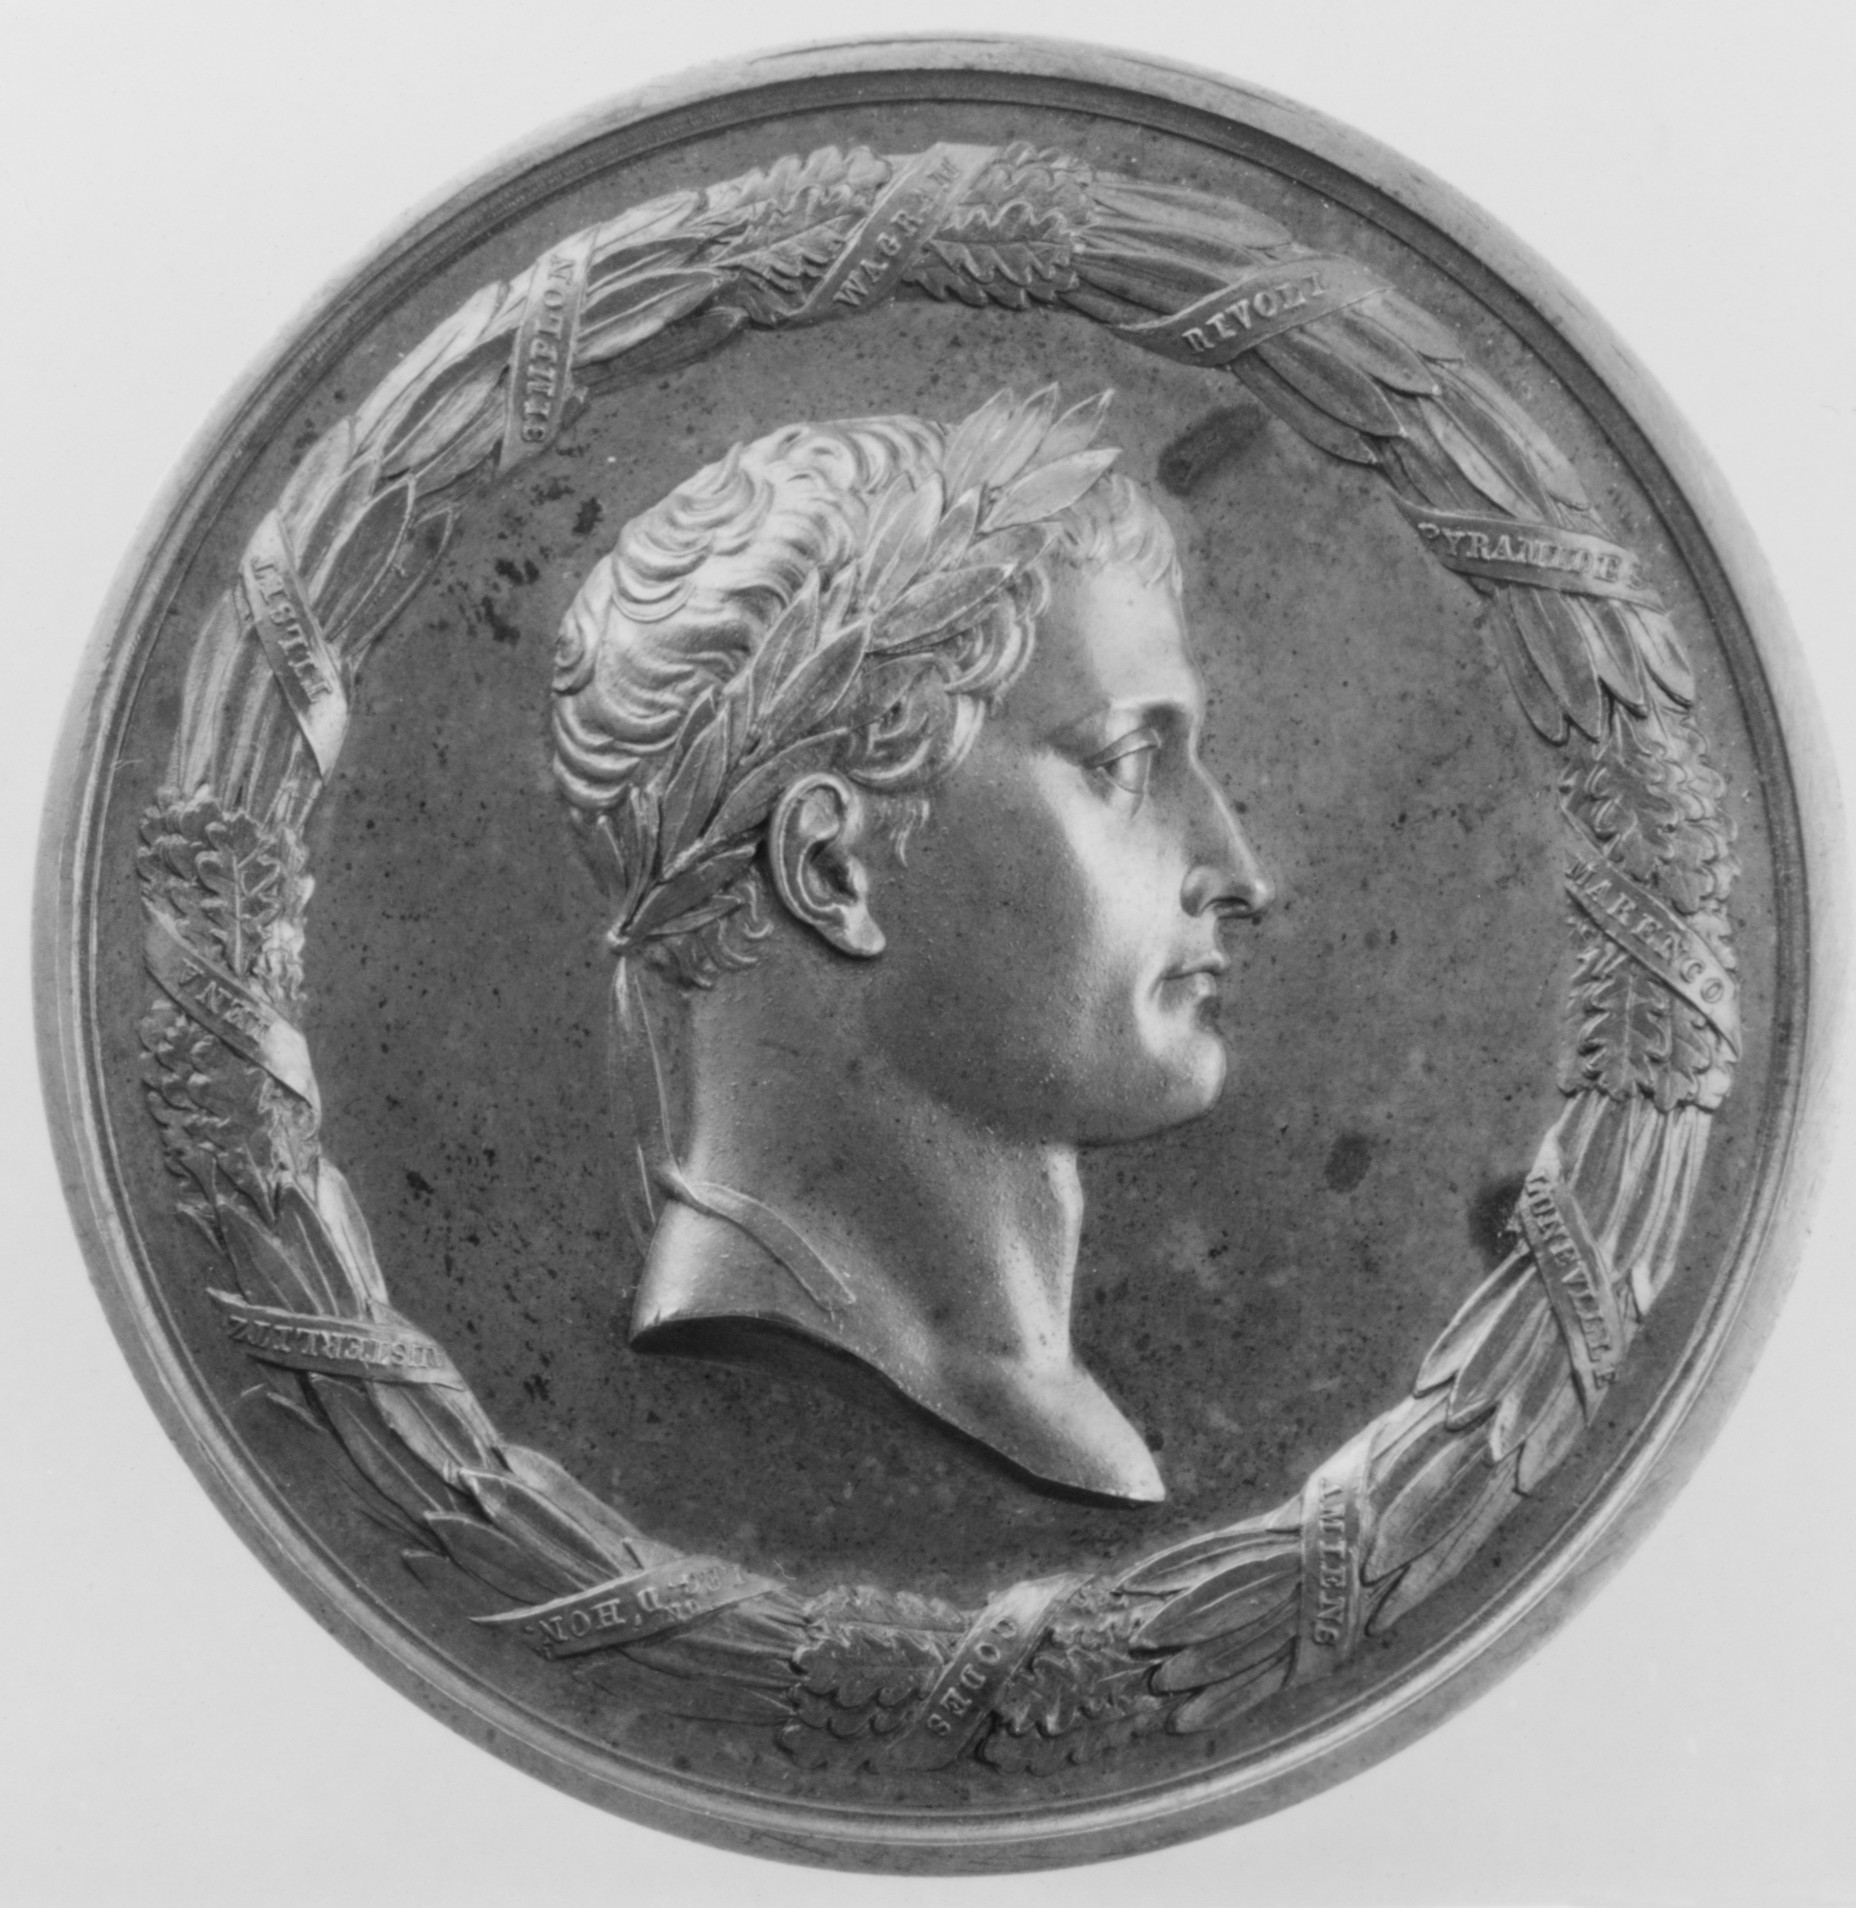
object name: medal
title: Napoleon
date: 1821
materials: bronze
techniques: struck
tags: birds,men,profiles,ships